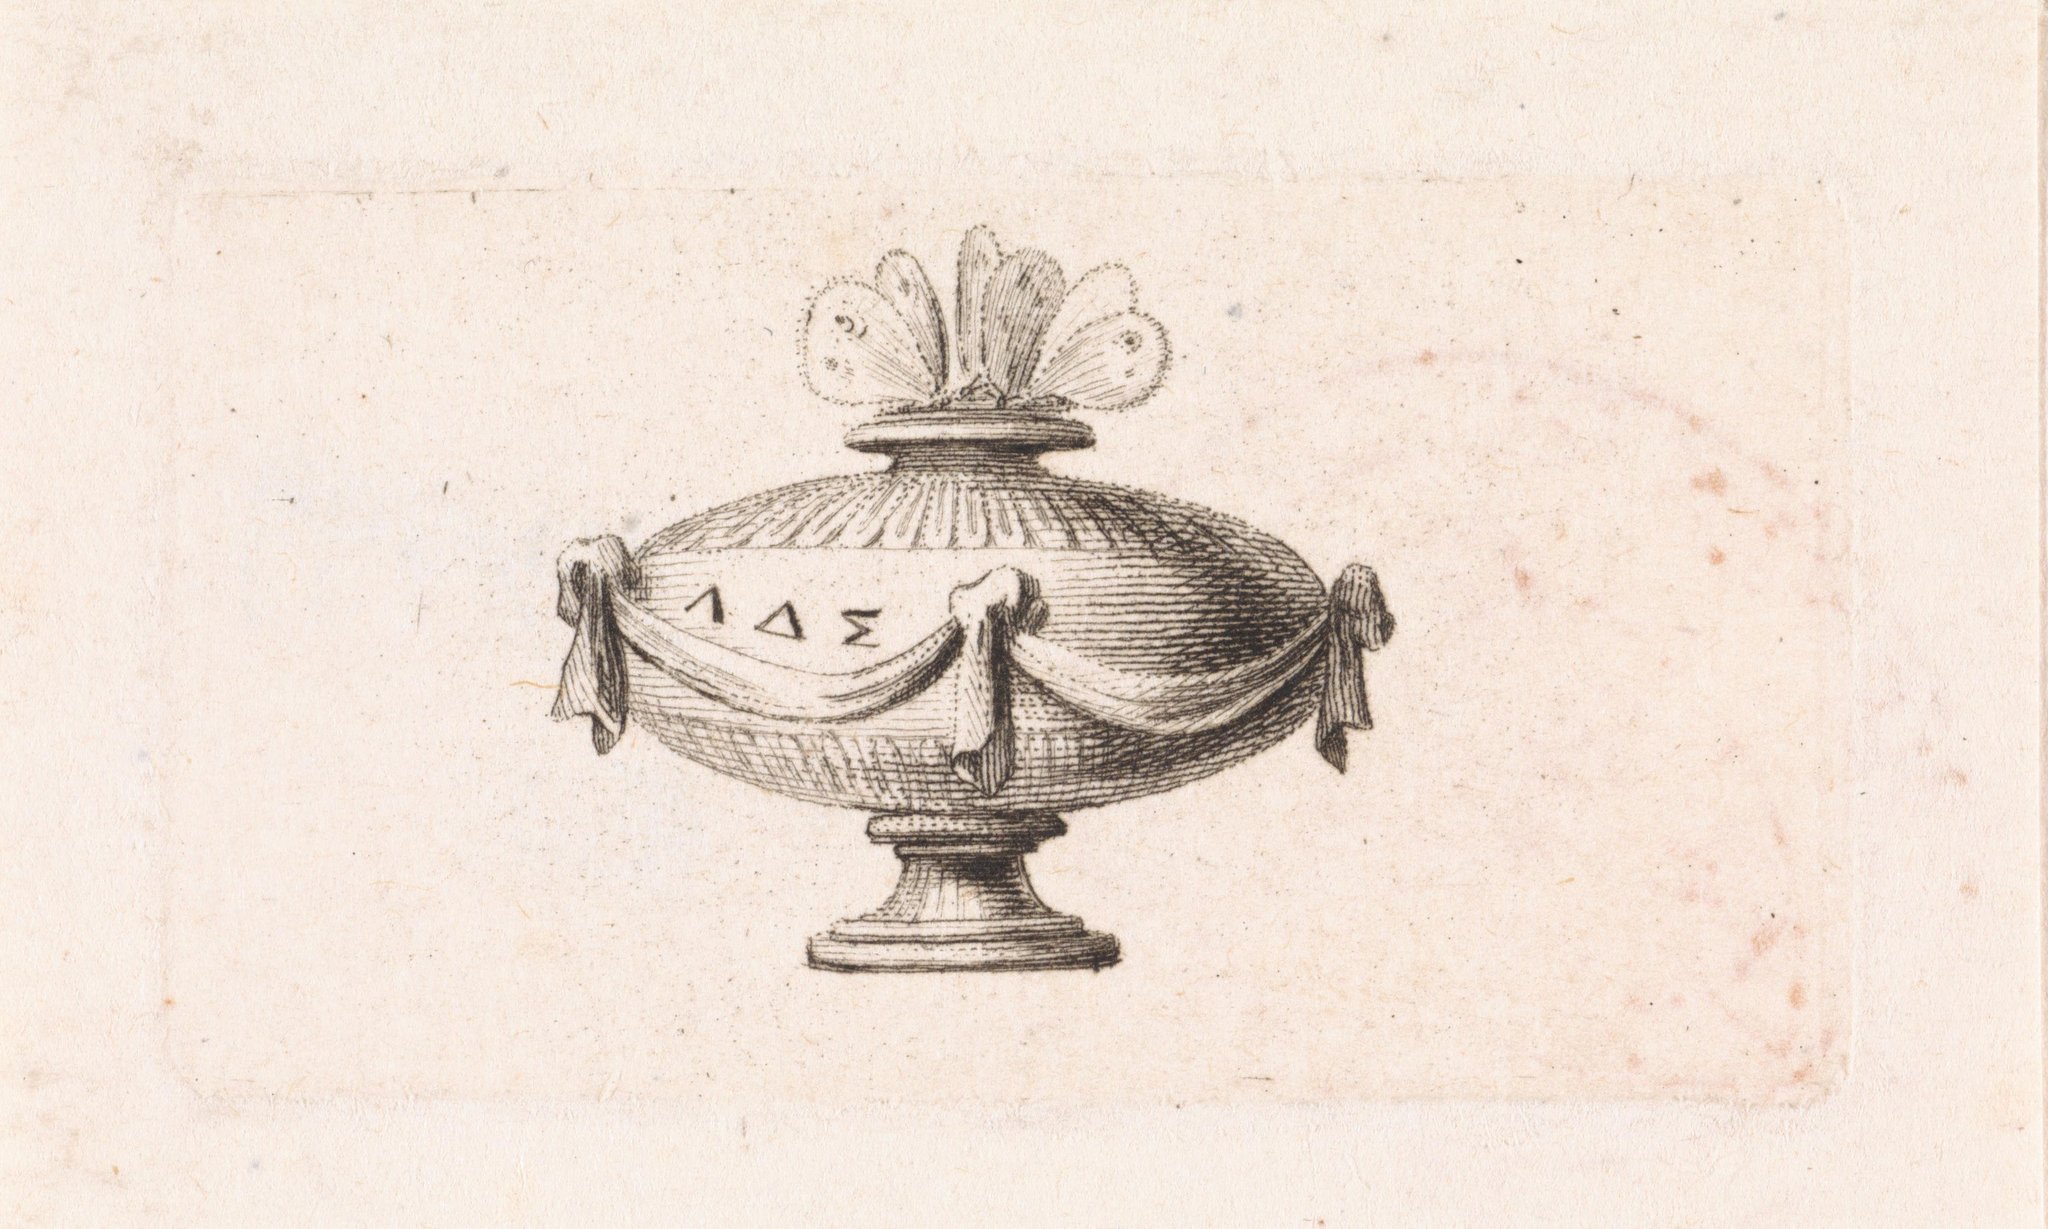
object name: print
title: Vlinders op een urn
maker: reinier vinkeles (i)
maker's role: draughtsman, print maker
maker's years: 1741-1816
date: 1751-1816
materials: paper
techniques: engraving, etching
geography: amsterdam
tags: urn, insects: butterfly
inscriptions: collector's mark: Lugt 240